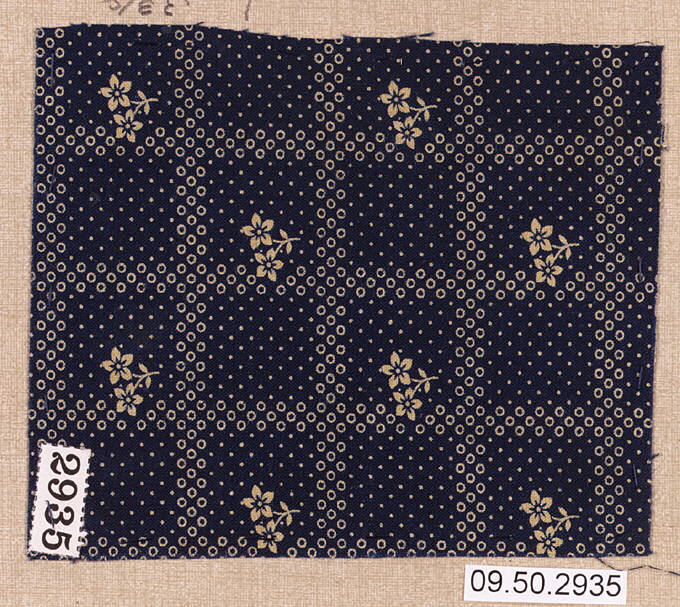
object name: piece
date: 1801-1900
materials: cotton